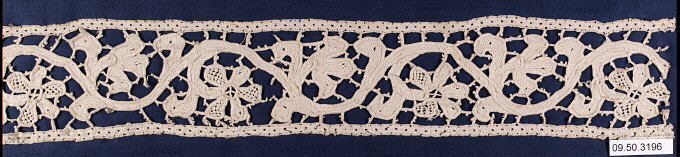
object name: strip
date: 1701-1800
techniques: lace